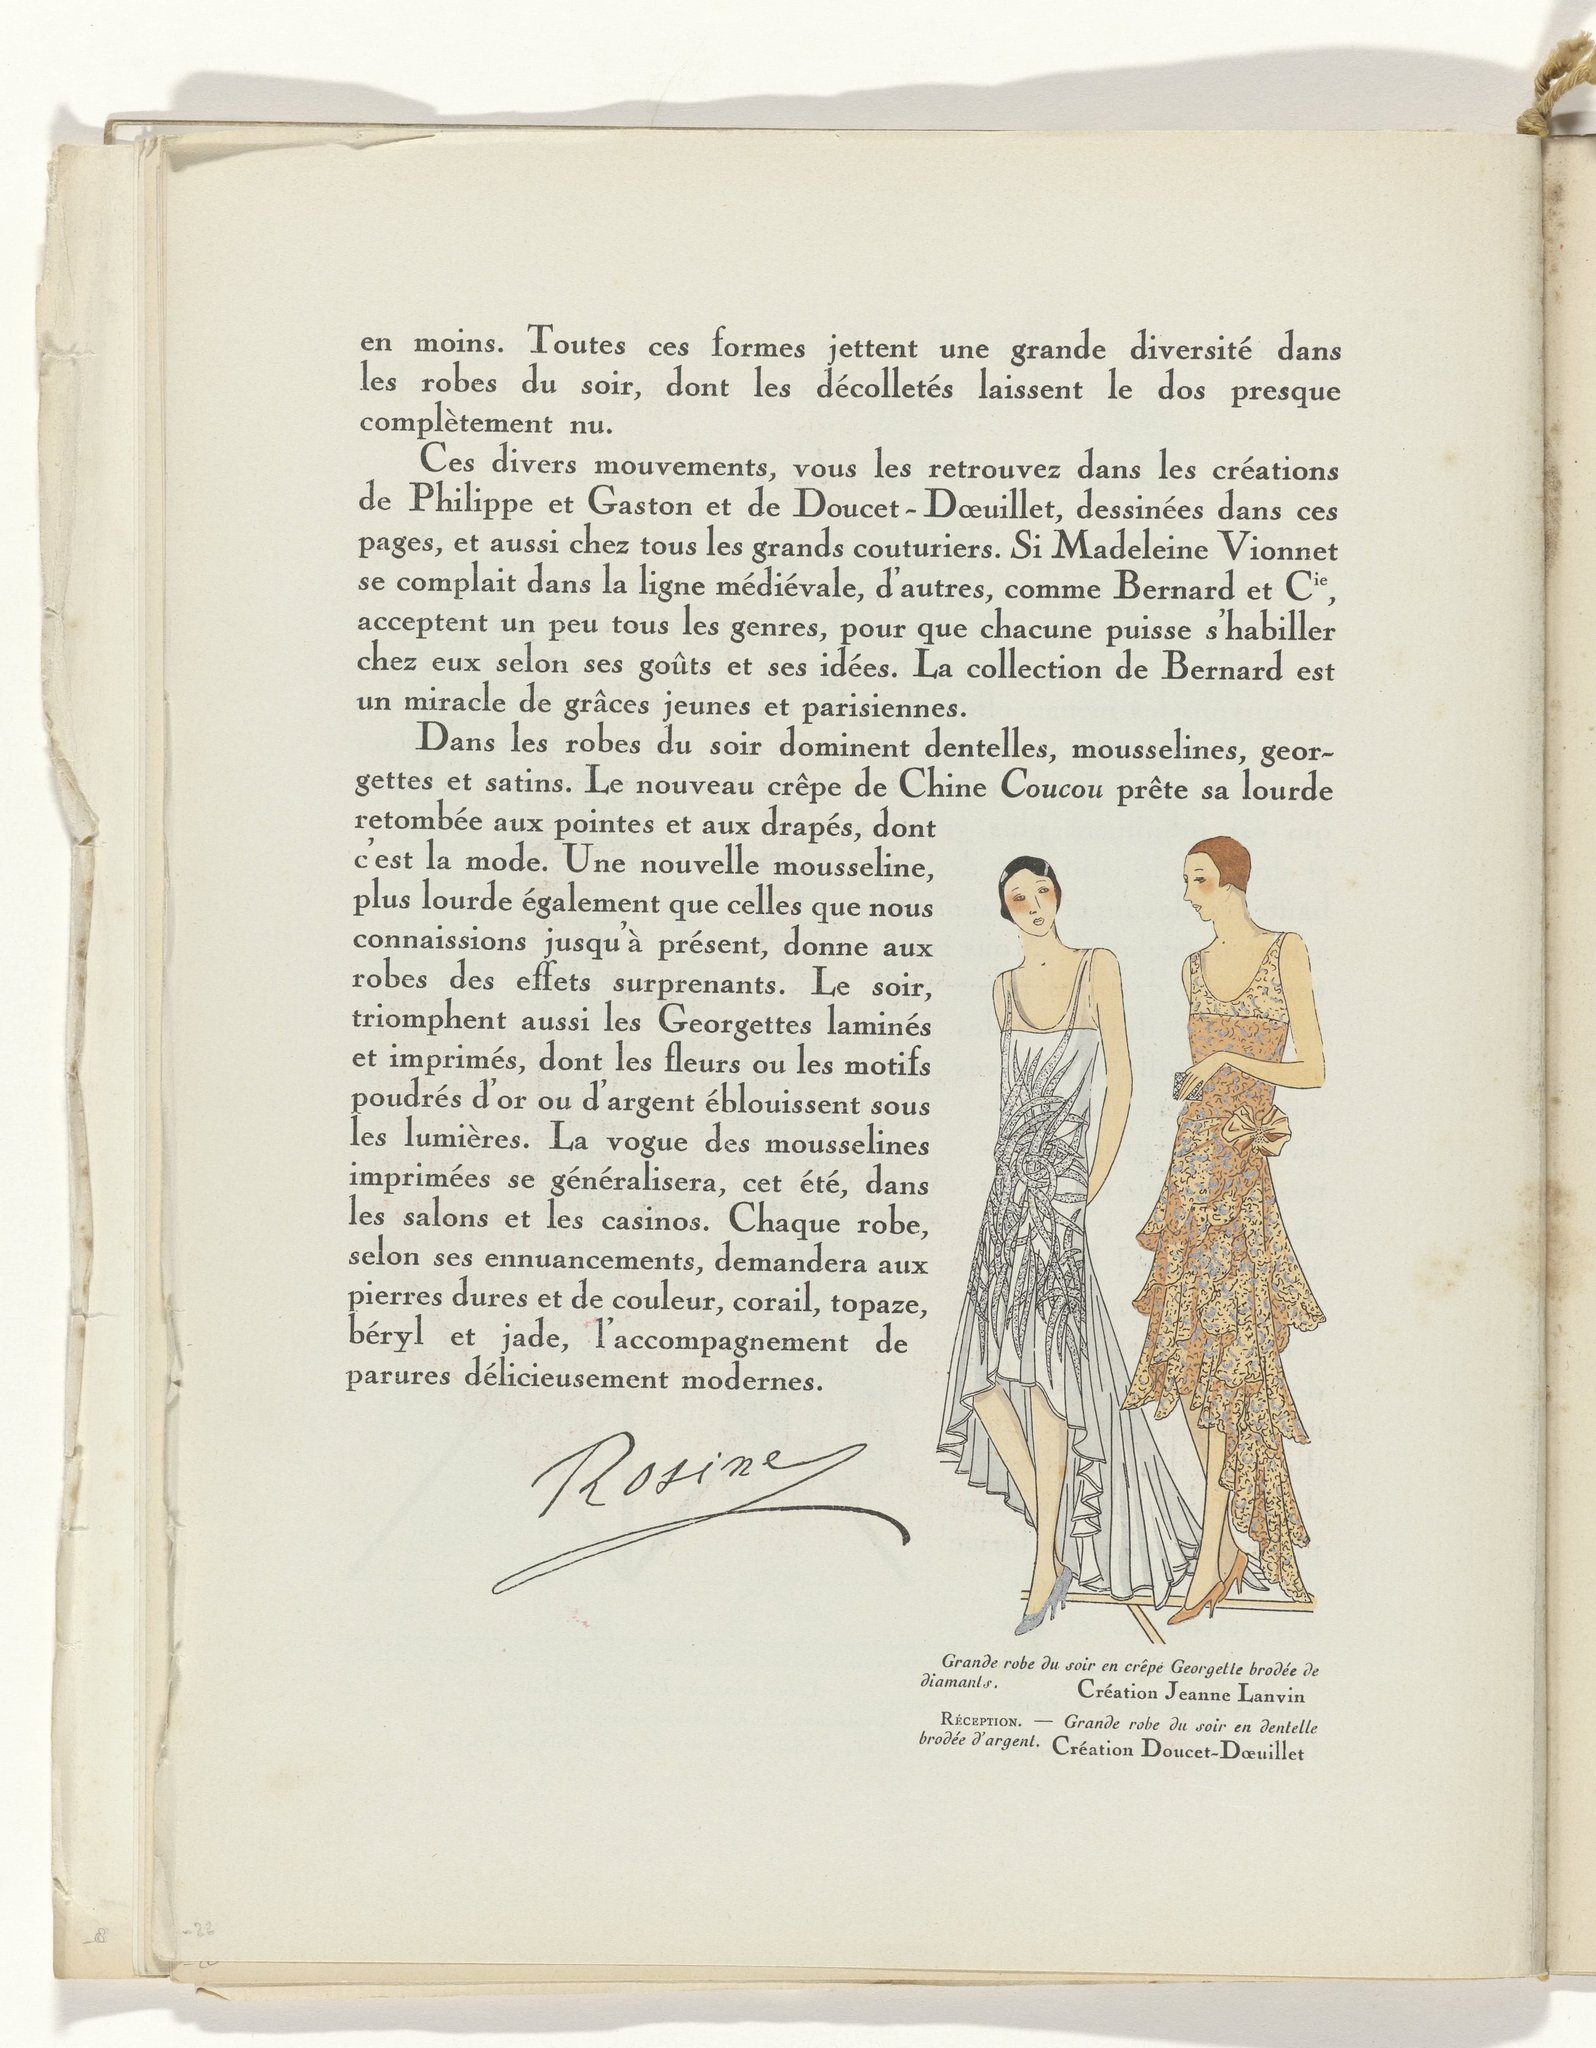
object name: fashion print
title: Art - Goût - Beauté, Feuillets de l' élégance féminine, Mars 1929, No. 103, 9e Année, p. 22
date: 1929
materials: paper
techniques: brush, hand coloring, lithograph, pochoir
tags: dress, gown: evening dress (+ women's clothes), embroidery (ornamentation) (+ women's clothes), lace (+ women's clothes), fashion plates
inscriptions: caption: ‘Grande robe du soir en crêpe Georgette brodée de diamants. Création Jeanne Lanvin / RÉCEPTION. - Grande robe du soir en dentelle brodée d'argent. Création Doucet-Doeuillet’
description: Tekst met illustratie van avondjurken. Links: avondjurk van Crêpe Georgette geborduurd met diamanten. Ontwerp van Jeanne Lanvin. Rechts: 'Réception": avondjurk van kant met zilverkleurig borduurwerk. Ontwerp van Doucet-Doeuillet. Pagina uit het modetijdschrift Art-Goût-Beauté (1920-1933).